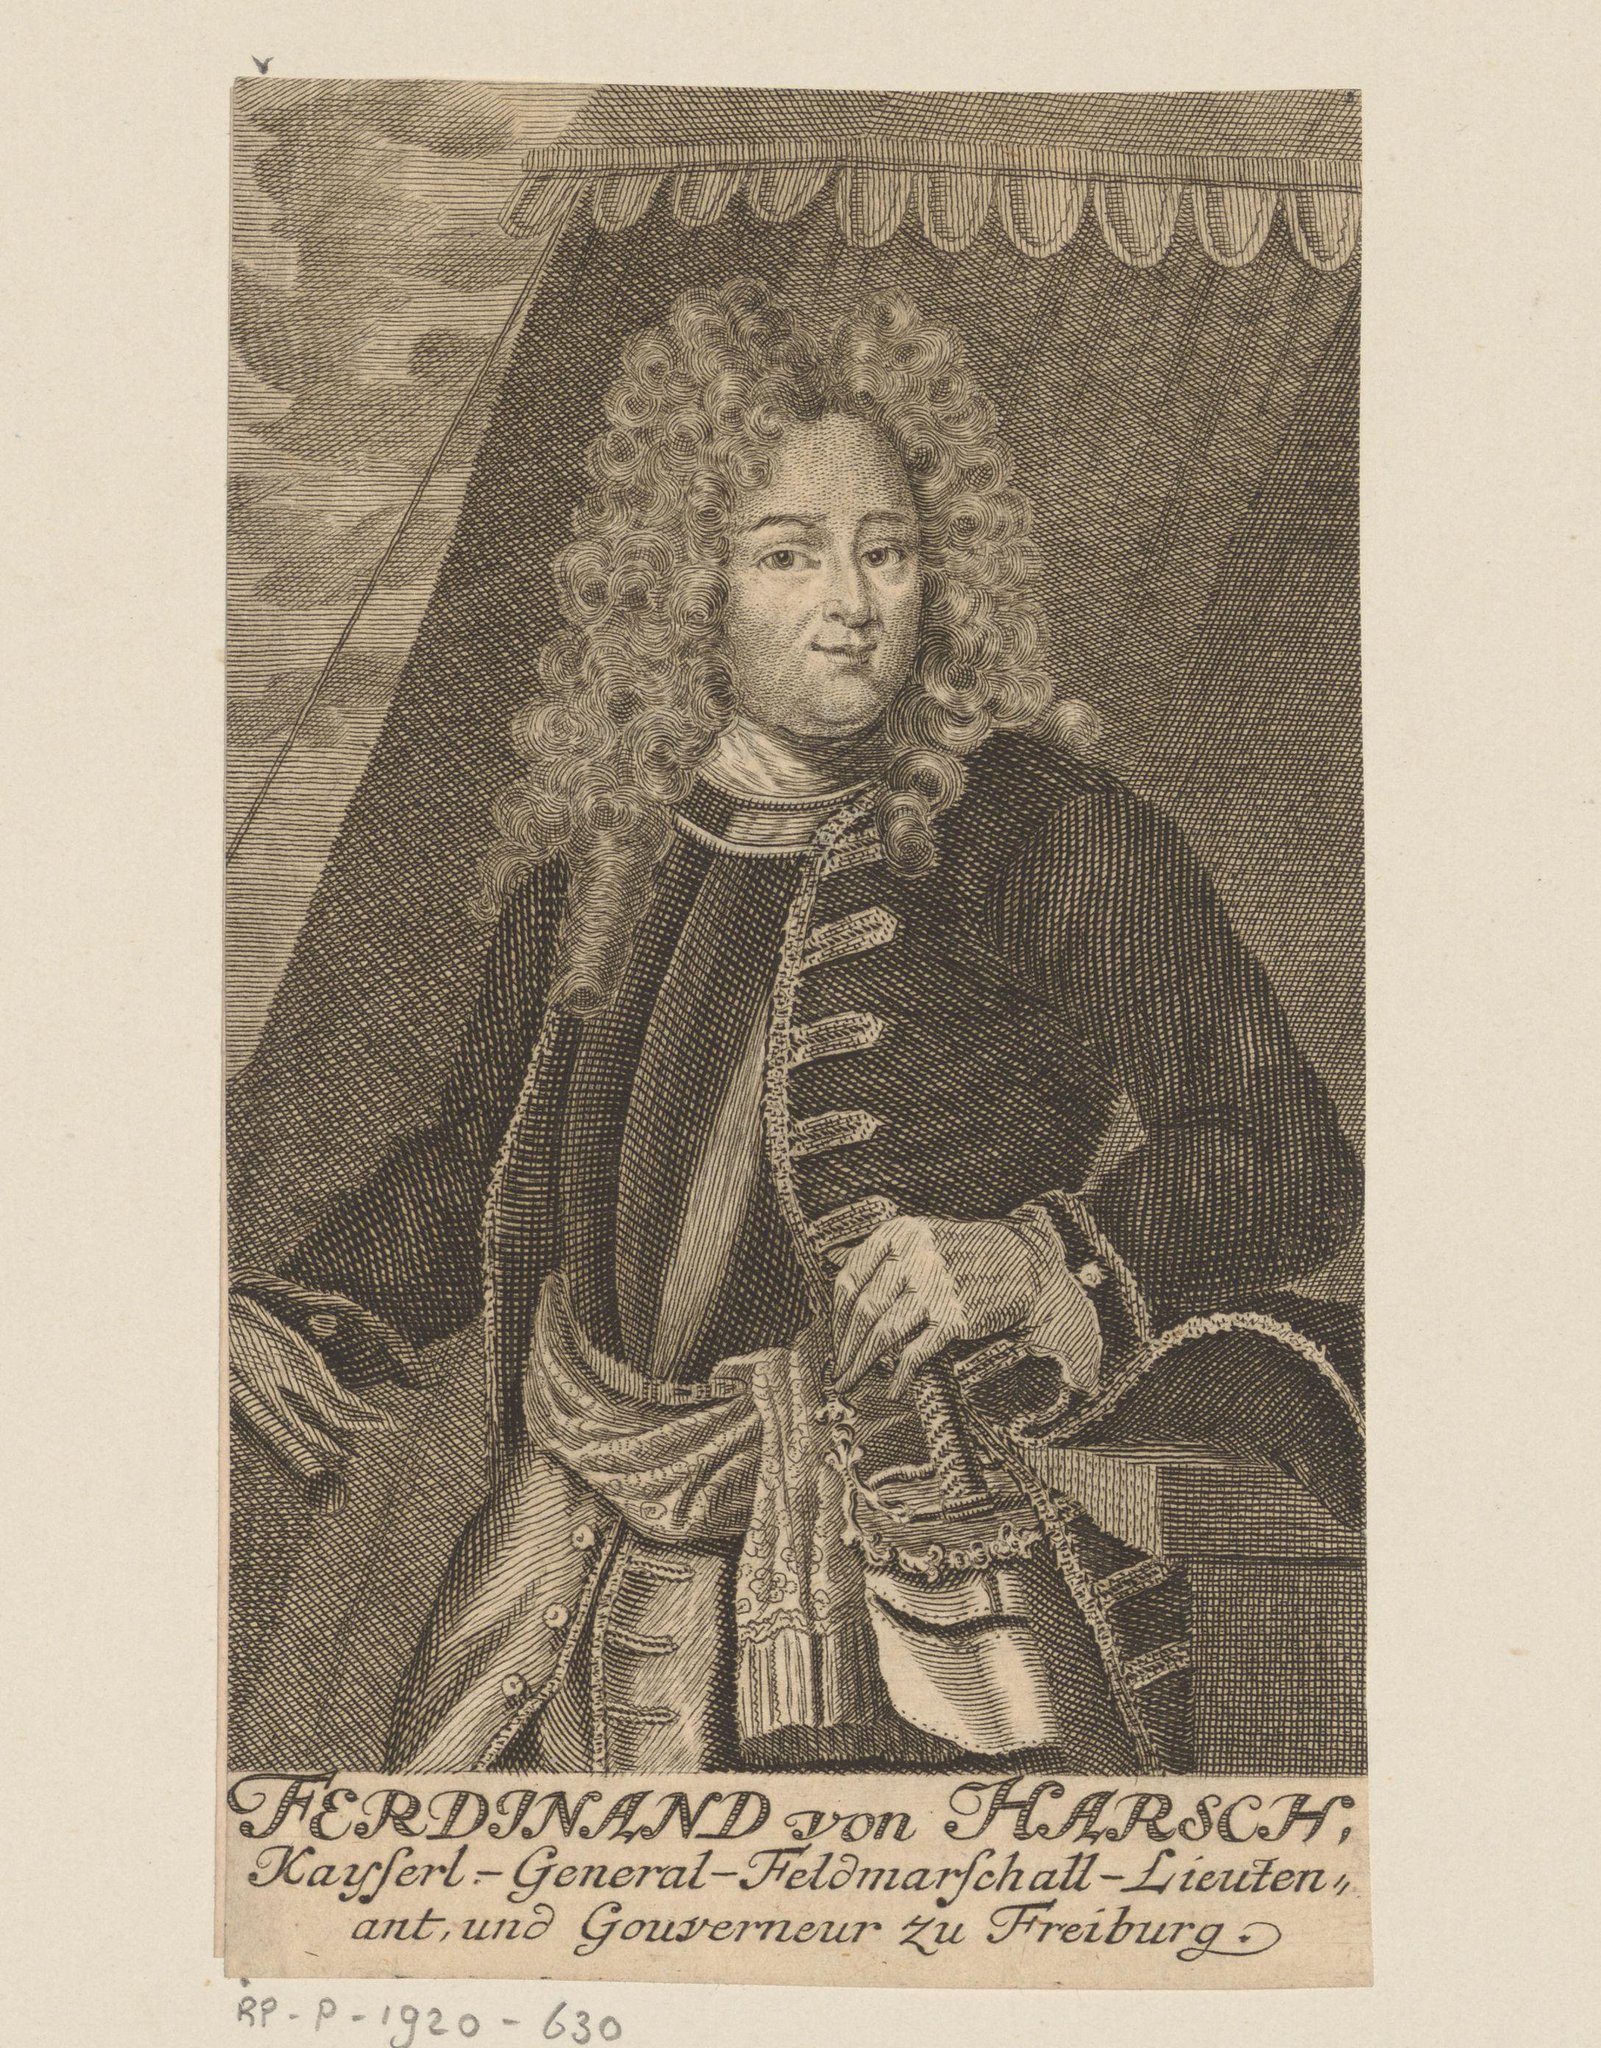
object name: print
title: Portret van Ferdinand Amadée von Harsch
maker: Anonymous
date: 1713-1749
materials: paper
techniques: engraving, etching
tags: commander-in-chief, general, marshal, historical persons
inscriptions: collector's mark: Lugt 2228